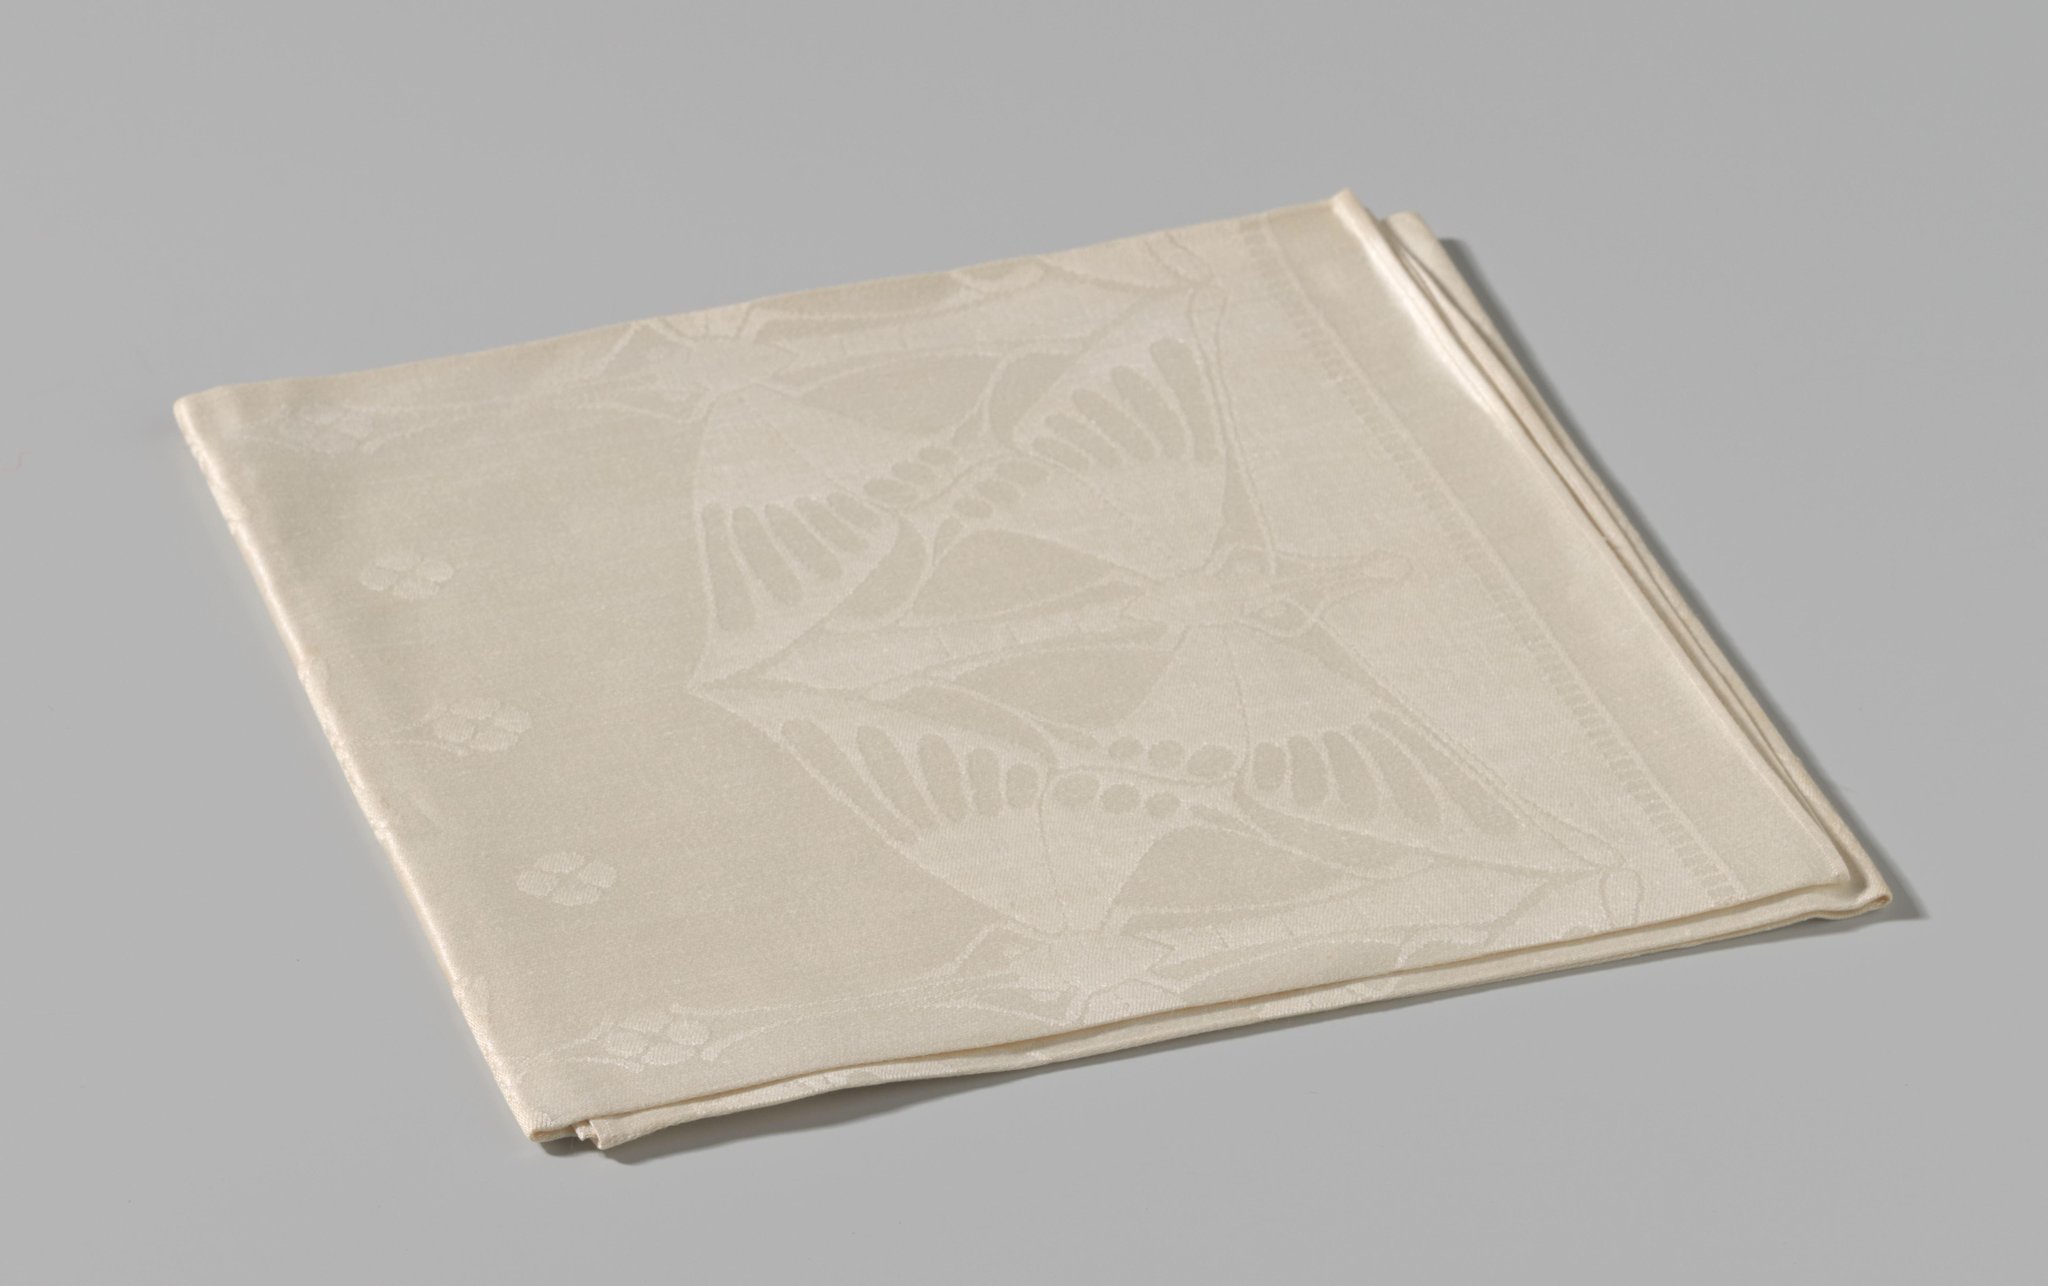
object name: napkin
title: Servet 'Vlinder' van linnendamast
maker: chris lebeau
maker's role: draughtsman, print maker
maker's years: 1878-1945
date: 1905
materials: linen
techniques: damask, weave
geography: eindhoven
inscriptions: mark: ‘VO’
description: Servet van linnendamast in vlindermotief. Het servet hoort bij vijf gelijke servetten (BK-1970-81-A t/m BK-1970-81-F) en een tafellaken (BK-1970-80).